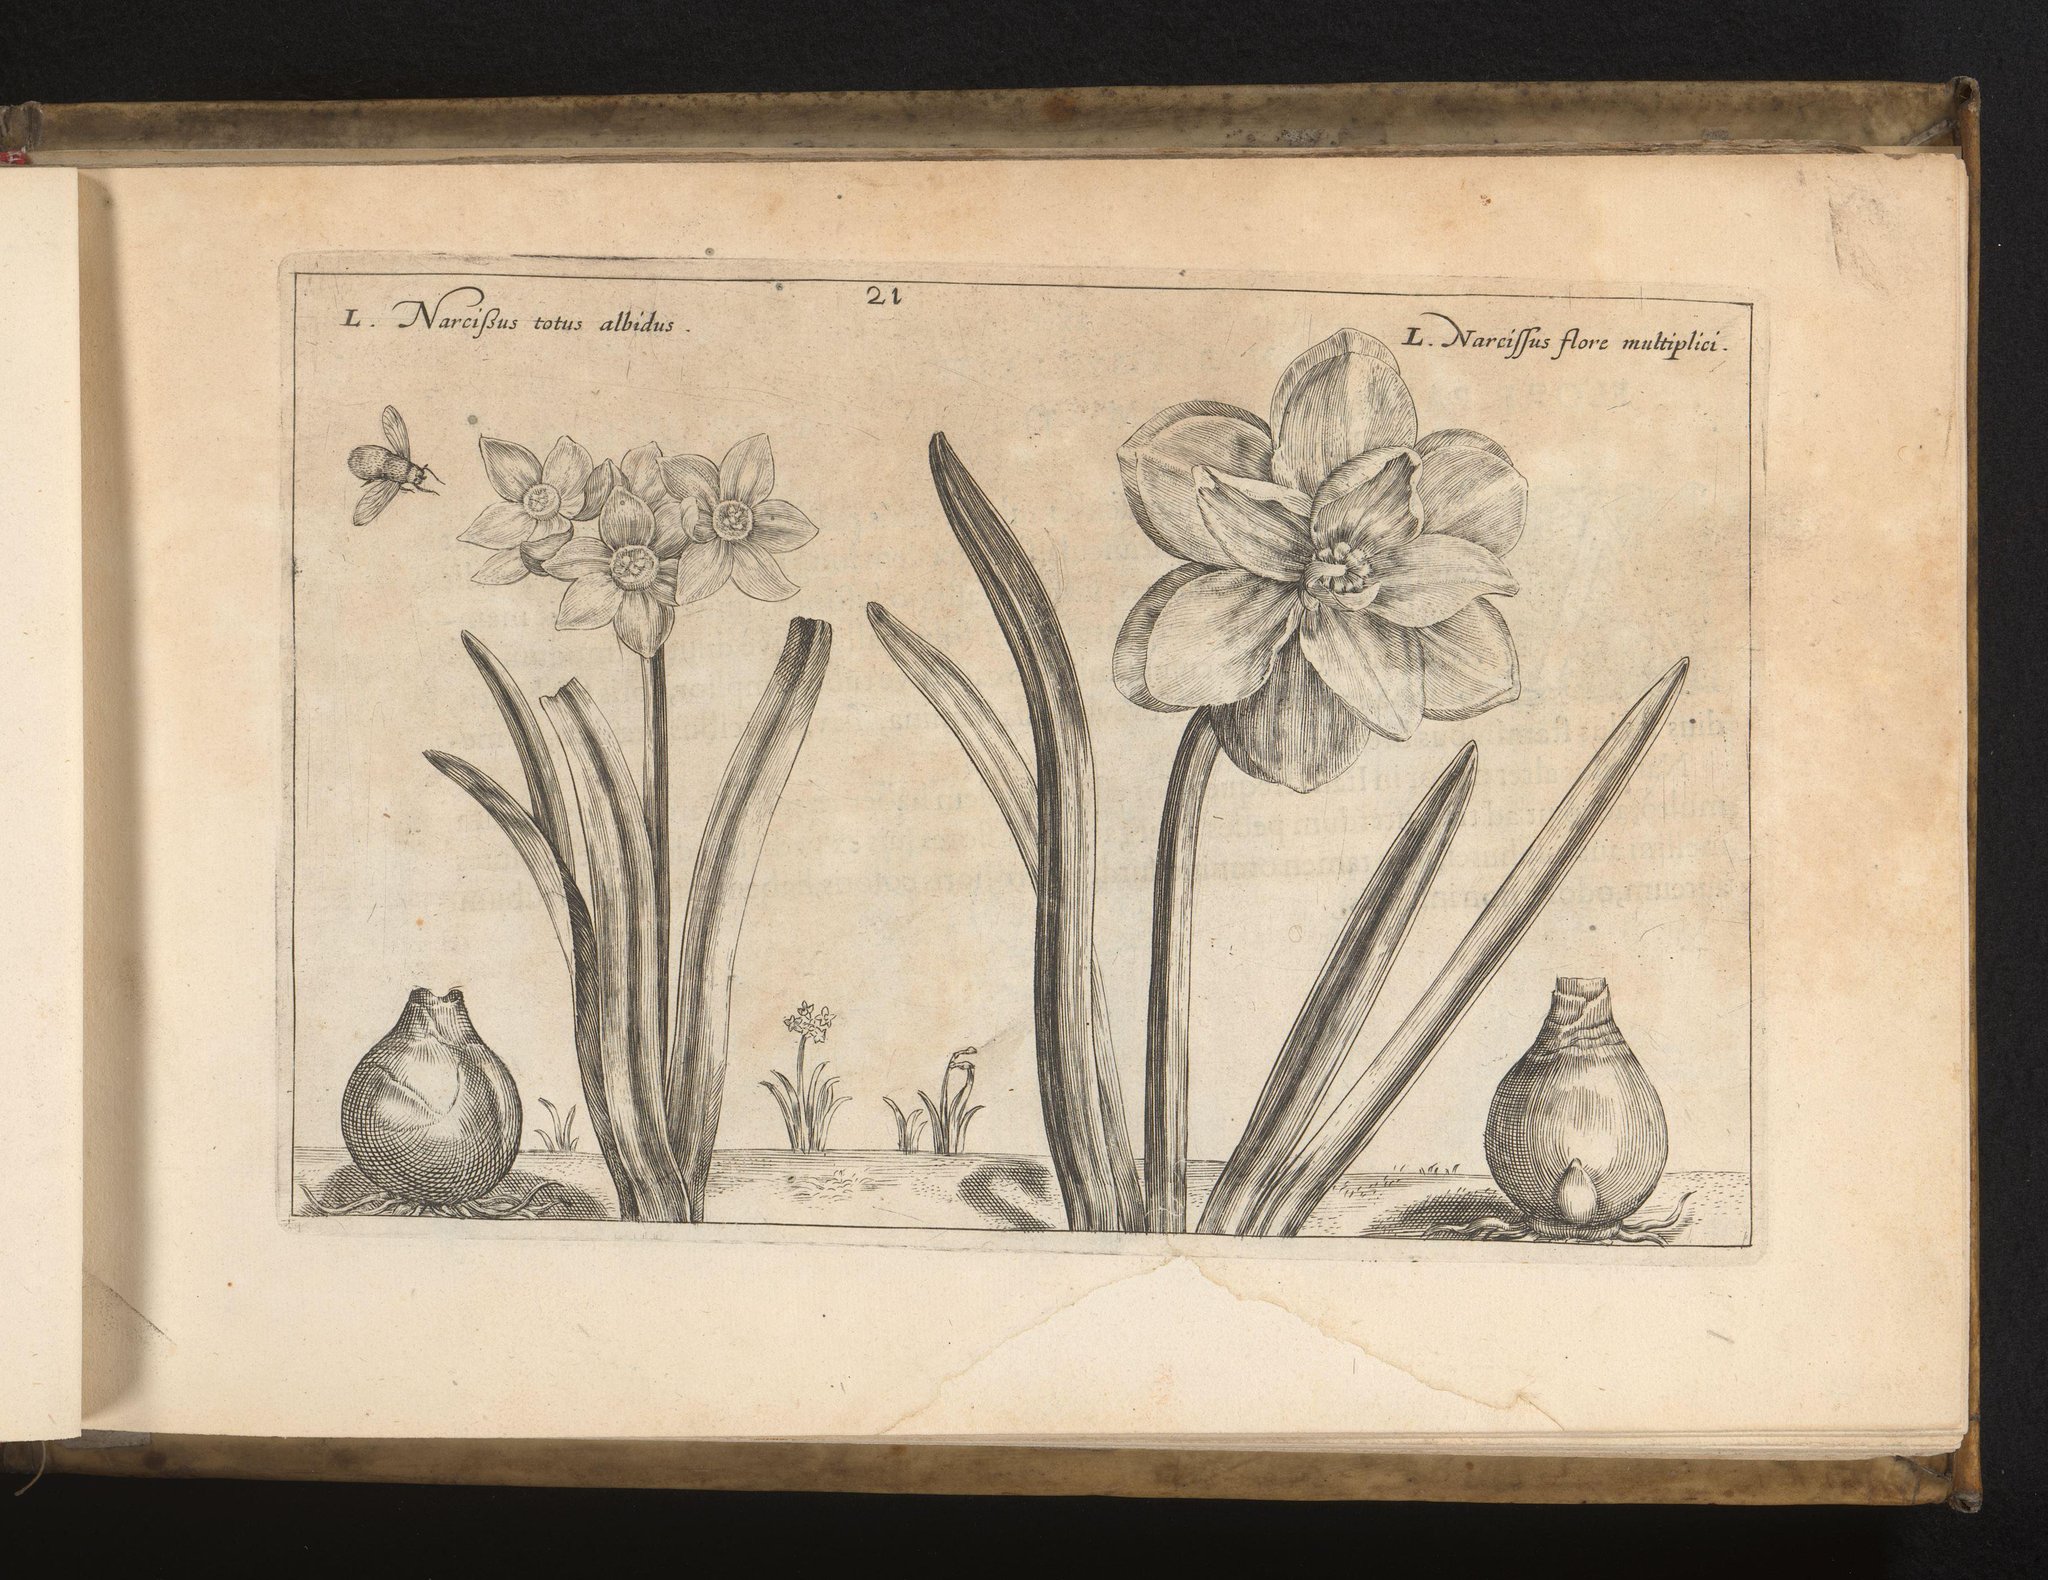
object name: page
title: Bloemtuin van de lente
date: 1617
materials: paper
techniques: engraving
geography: utrecht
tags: flowers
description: Prent uit: Passe, Crispijn van de (II). Hortus floridus in quo rariorum & minus vulgarium florum icones ad vivam veramque formam. Arnhem: Johannes Janssonius, 1617.